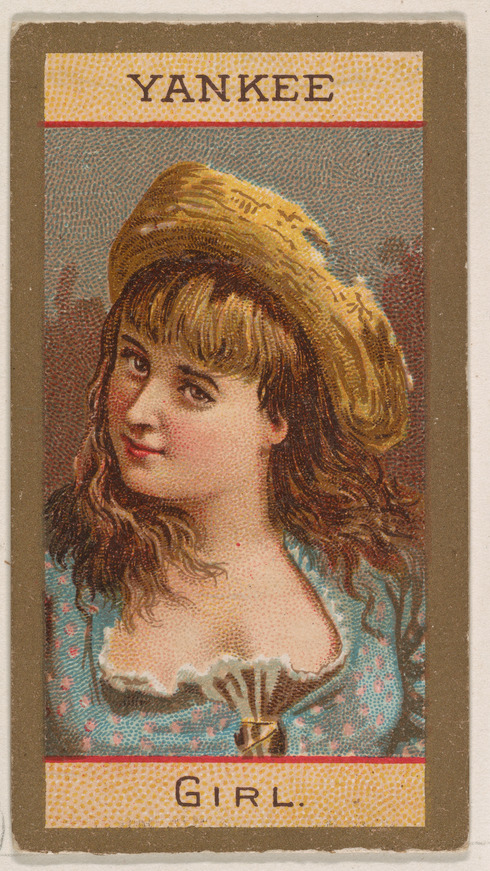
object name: print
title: Yankee Girl, from Types of Nationalities (N240) issued by Kinney Bros.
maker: kinney brothers tobacco company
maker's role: publisher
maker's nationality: american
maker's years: 1869-2011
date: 1890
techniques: color lithograph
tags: women